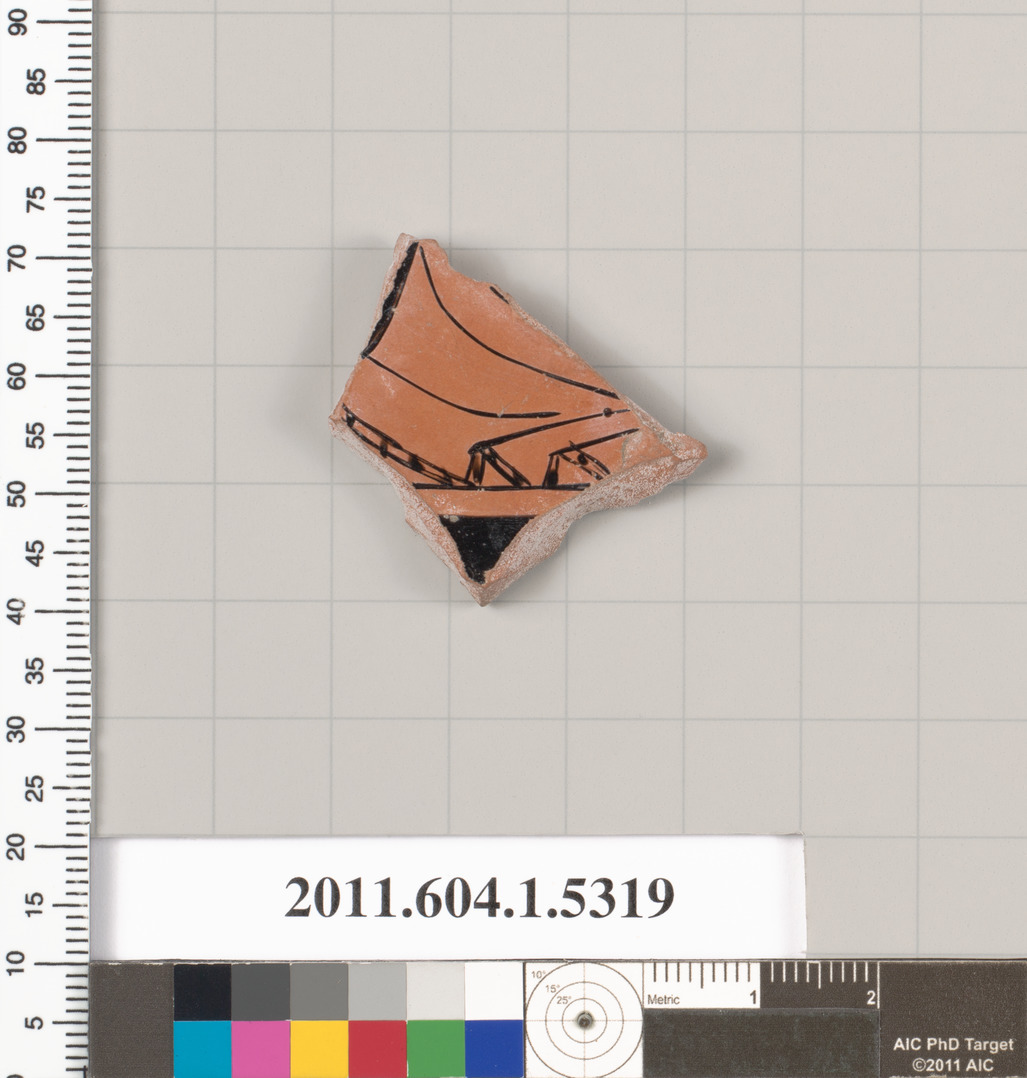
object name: kylix fragment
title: Terracotta fragment of a kylix (drinking cup)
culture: greek, attic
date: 500-480 BCE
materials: terracotta